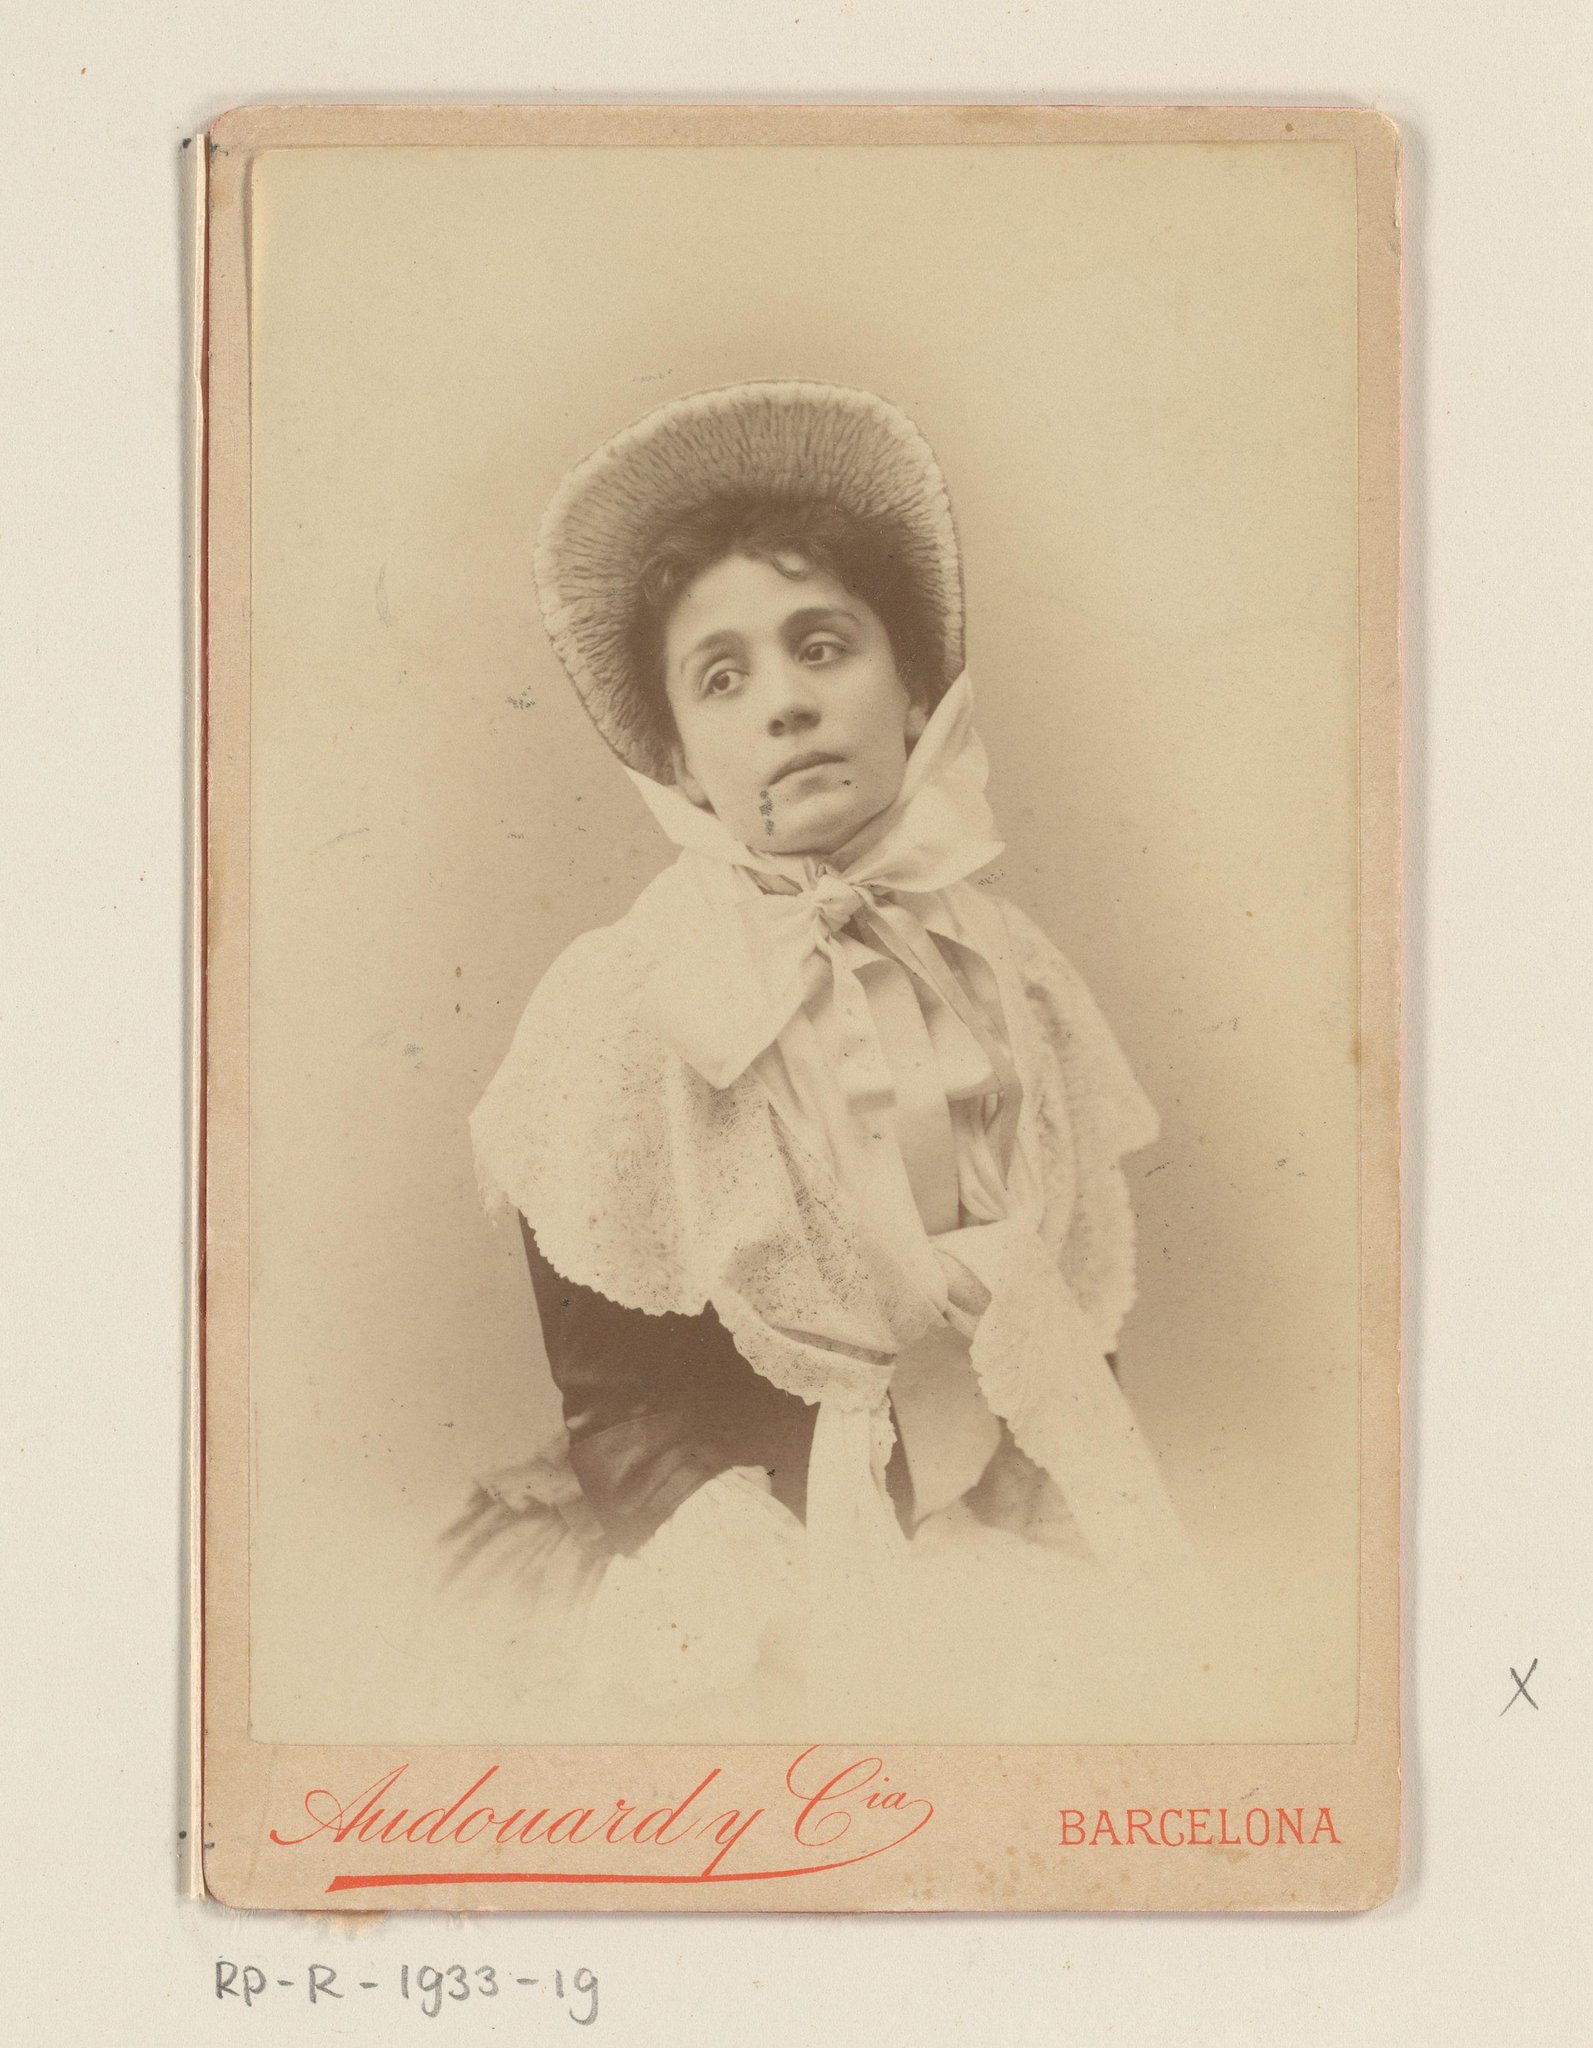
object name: cabinet photograph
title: Portret van Eleonora Duse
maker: pau audouard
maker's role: fotograaf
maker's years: 1857-1918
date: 1890-1905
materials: cardboard, paper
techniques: albumen print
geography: barcelona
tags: portrait of actor, actress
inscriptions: inscription: ‘Eleonore Dusé.’, inscription: ‘Audouard y Cia/ FOTÓGRAFOS/ HDIFICIO CONSTRUIDO EXPROFESO PARA GALÉRIA FOTOGRAFICA Y TALLER HIPICC[...]/ CONCESIONARIOS DE LA FOTOGRAFIA EN LA EXPOSICION UNIVERSAL DE 1888/ TELEFONO 12 351/ Calle de las Cortes 273 y 275/ Barcelona/ L&D. PARIS’